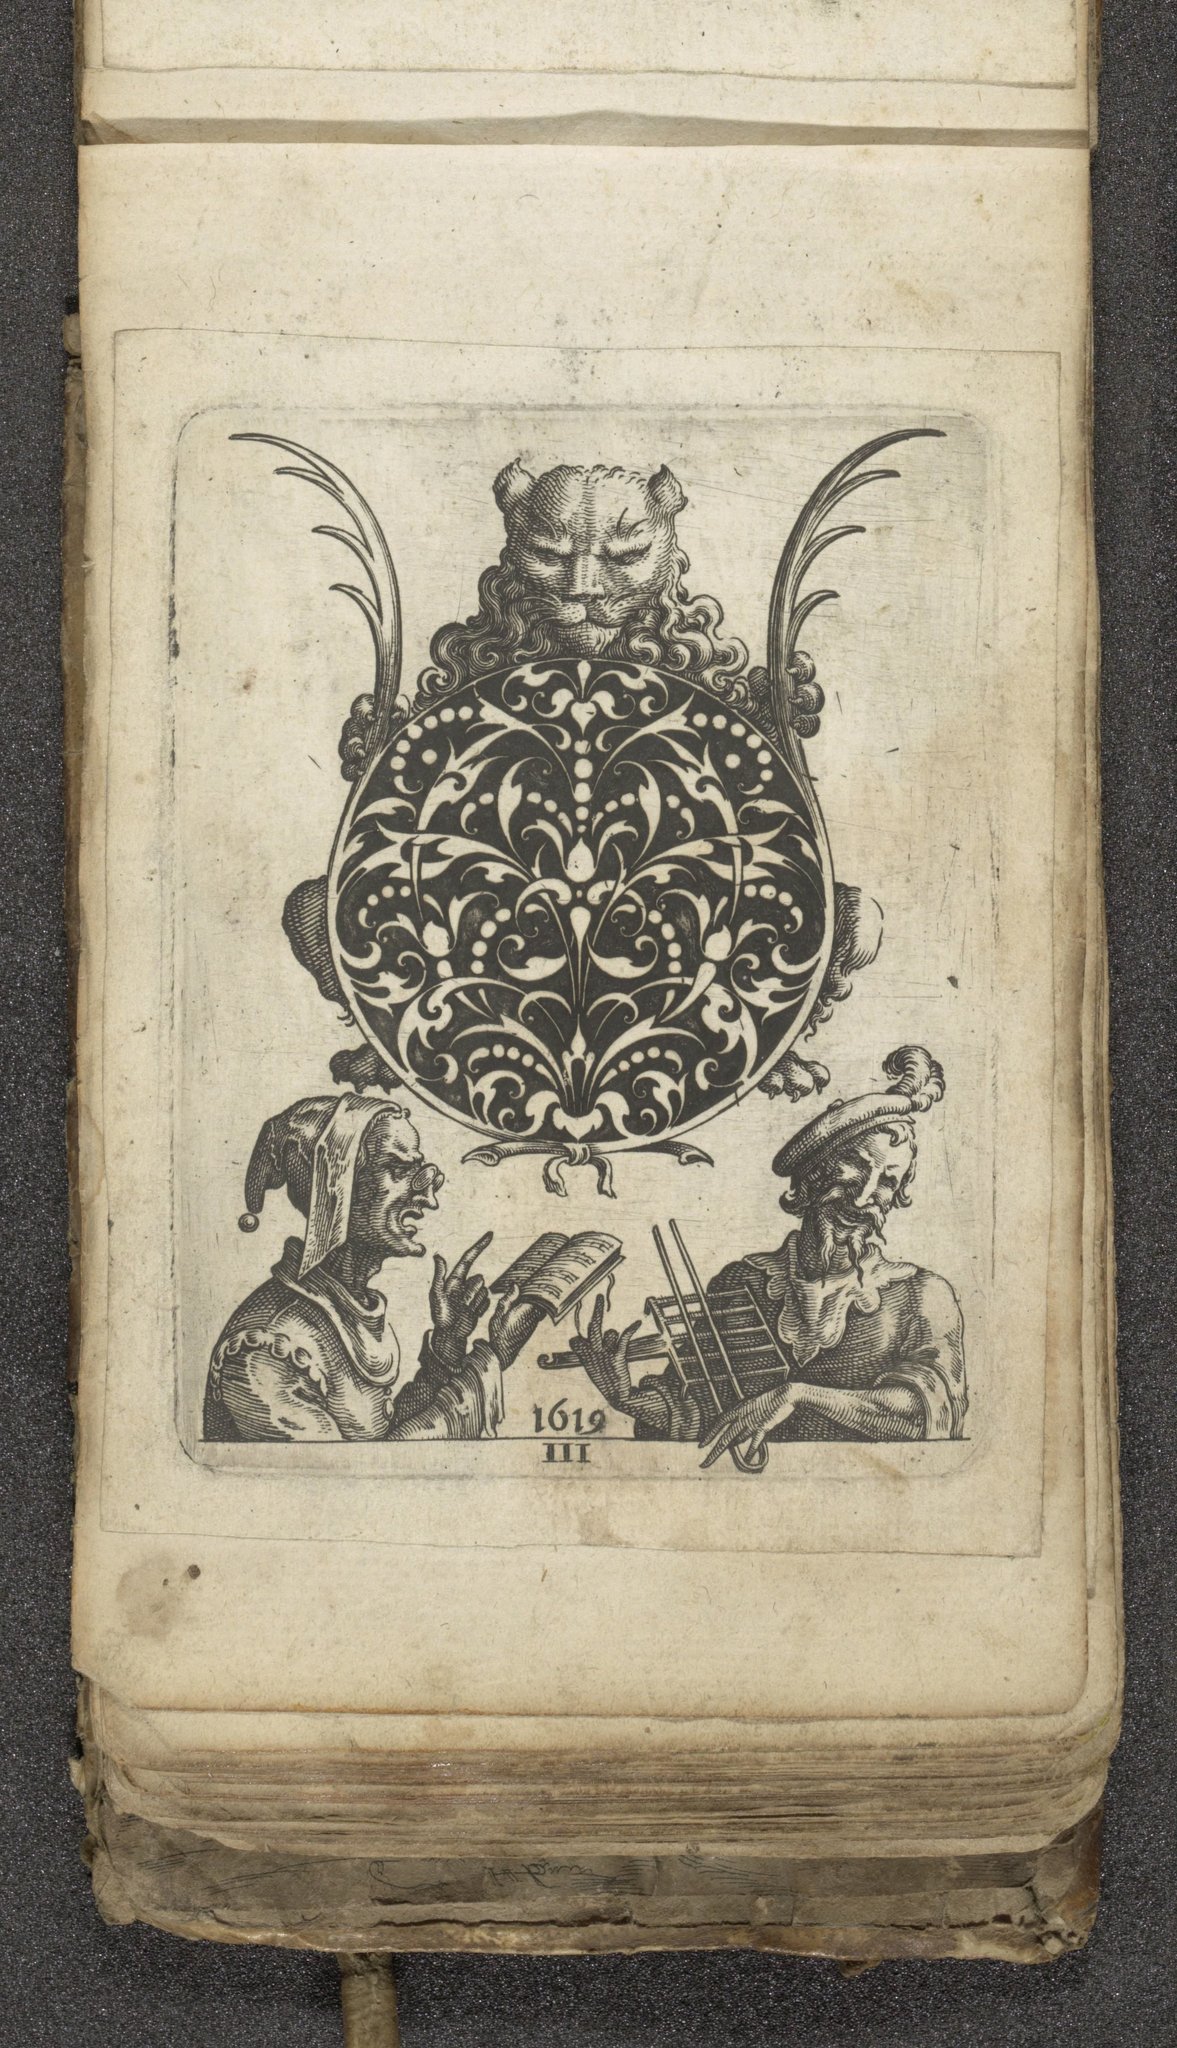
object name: print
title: Zwartornamenten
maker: jean toutin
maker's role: print maker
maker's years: 1578-1644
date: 1619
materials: paper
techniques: engraving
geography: châteaudun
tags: lion's head ~ ornament, musician, ornaments ~ art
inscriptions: inscription: ‘64’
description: Rond zwartornament vastgehouden door een leeuw met palmbladeren. Daaronder twee muzikanten: links een zanger met zottekap en bril, rechts een man met gevederde baret. Hij speelt met een tang op een rooster. Onderaan genummerd III. De prent maakt deel uit van een album.